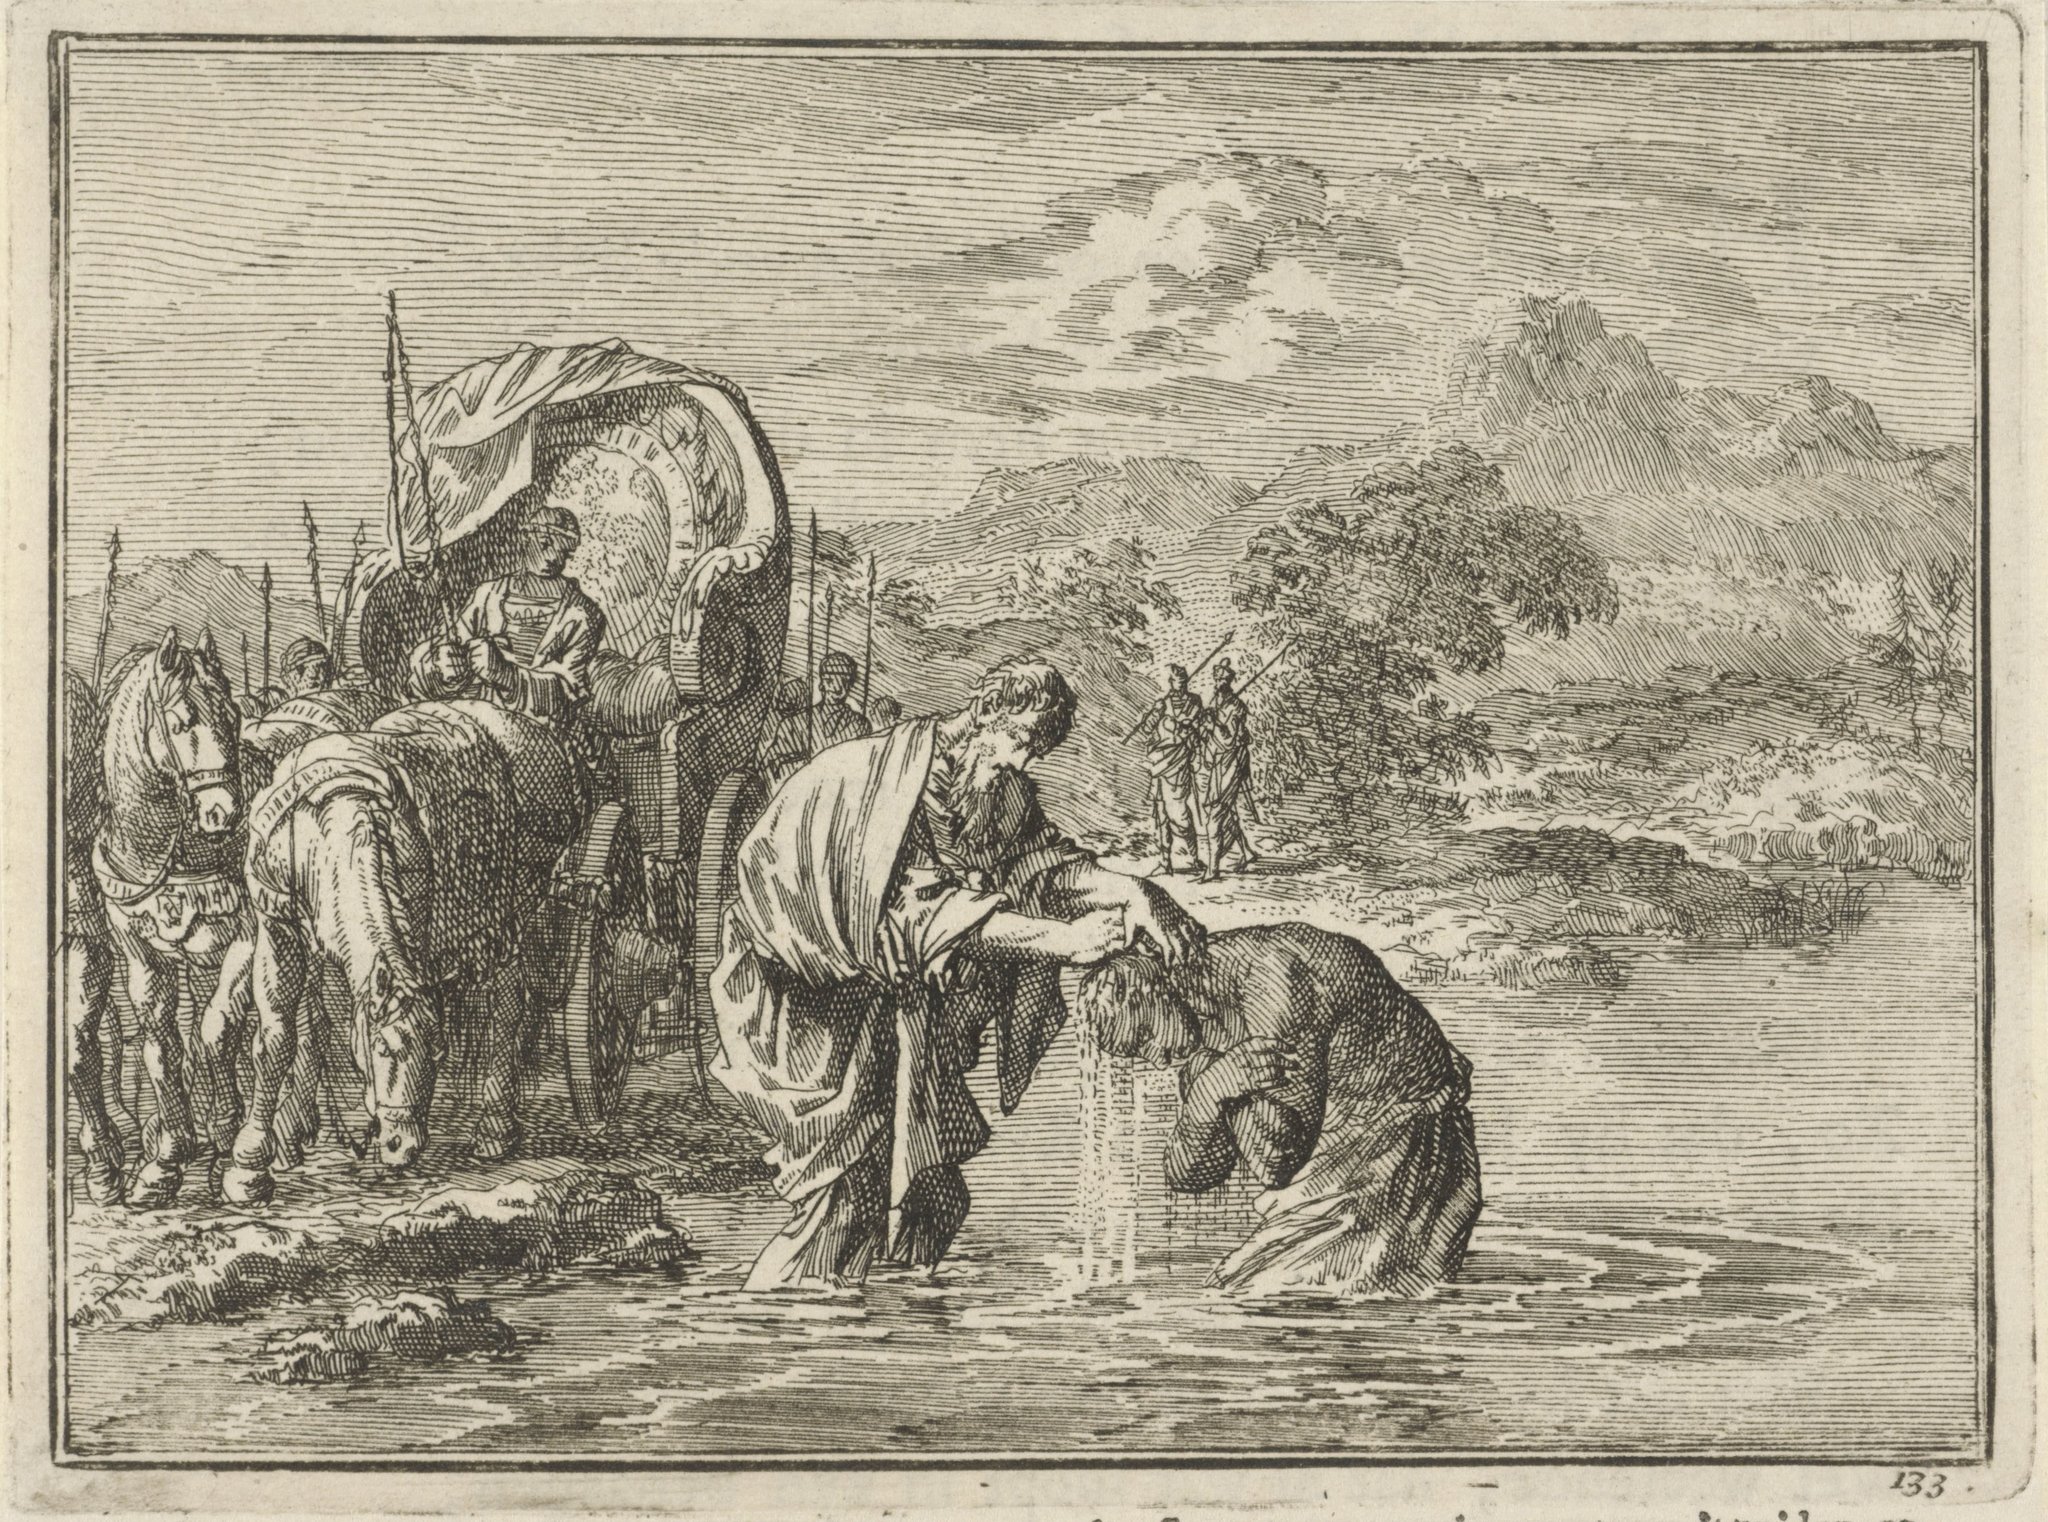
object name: book illustration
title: Doop van de kamerling door Philippus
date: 1712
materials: paper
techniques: etching, letterpress printing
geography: amsterdam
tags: philip baptizes the eunuch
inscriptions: collector's mark: Lugt 2228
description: Illustratie uit: Luyken, Jan. De schriftuurlyke geschiedenissen en gelykenissen van het Oude en Nieuwe Verbond, 2 delen. Amsterdam: Wed. Pieter Arentsz II en Cornelis van der Sys, 1712, dl. II.